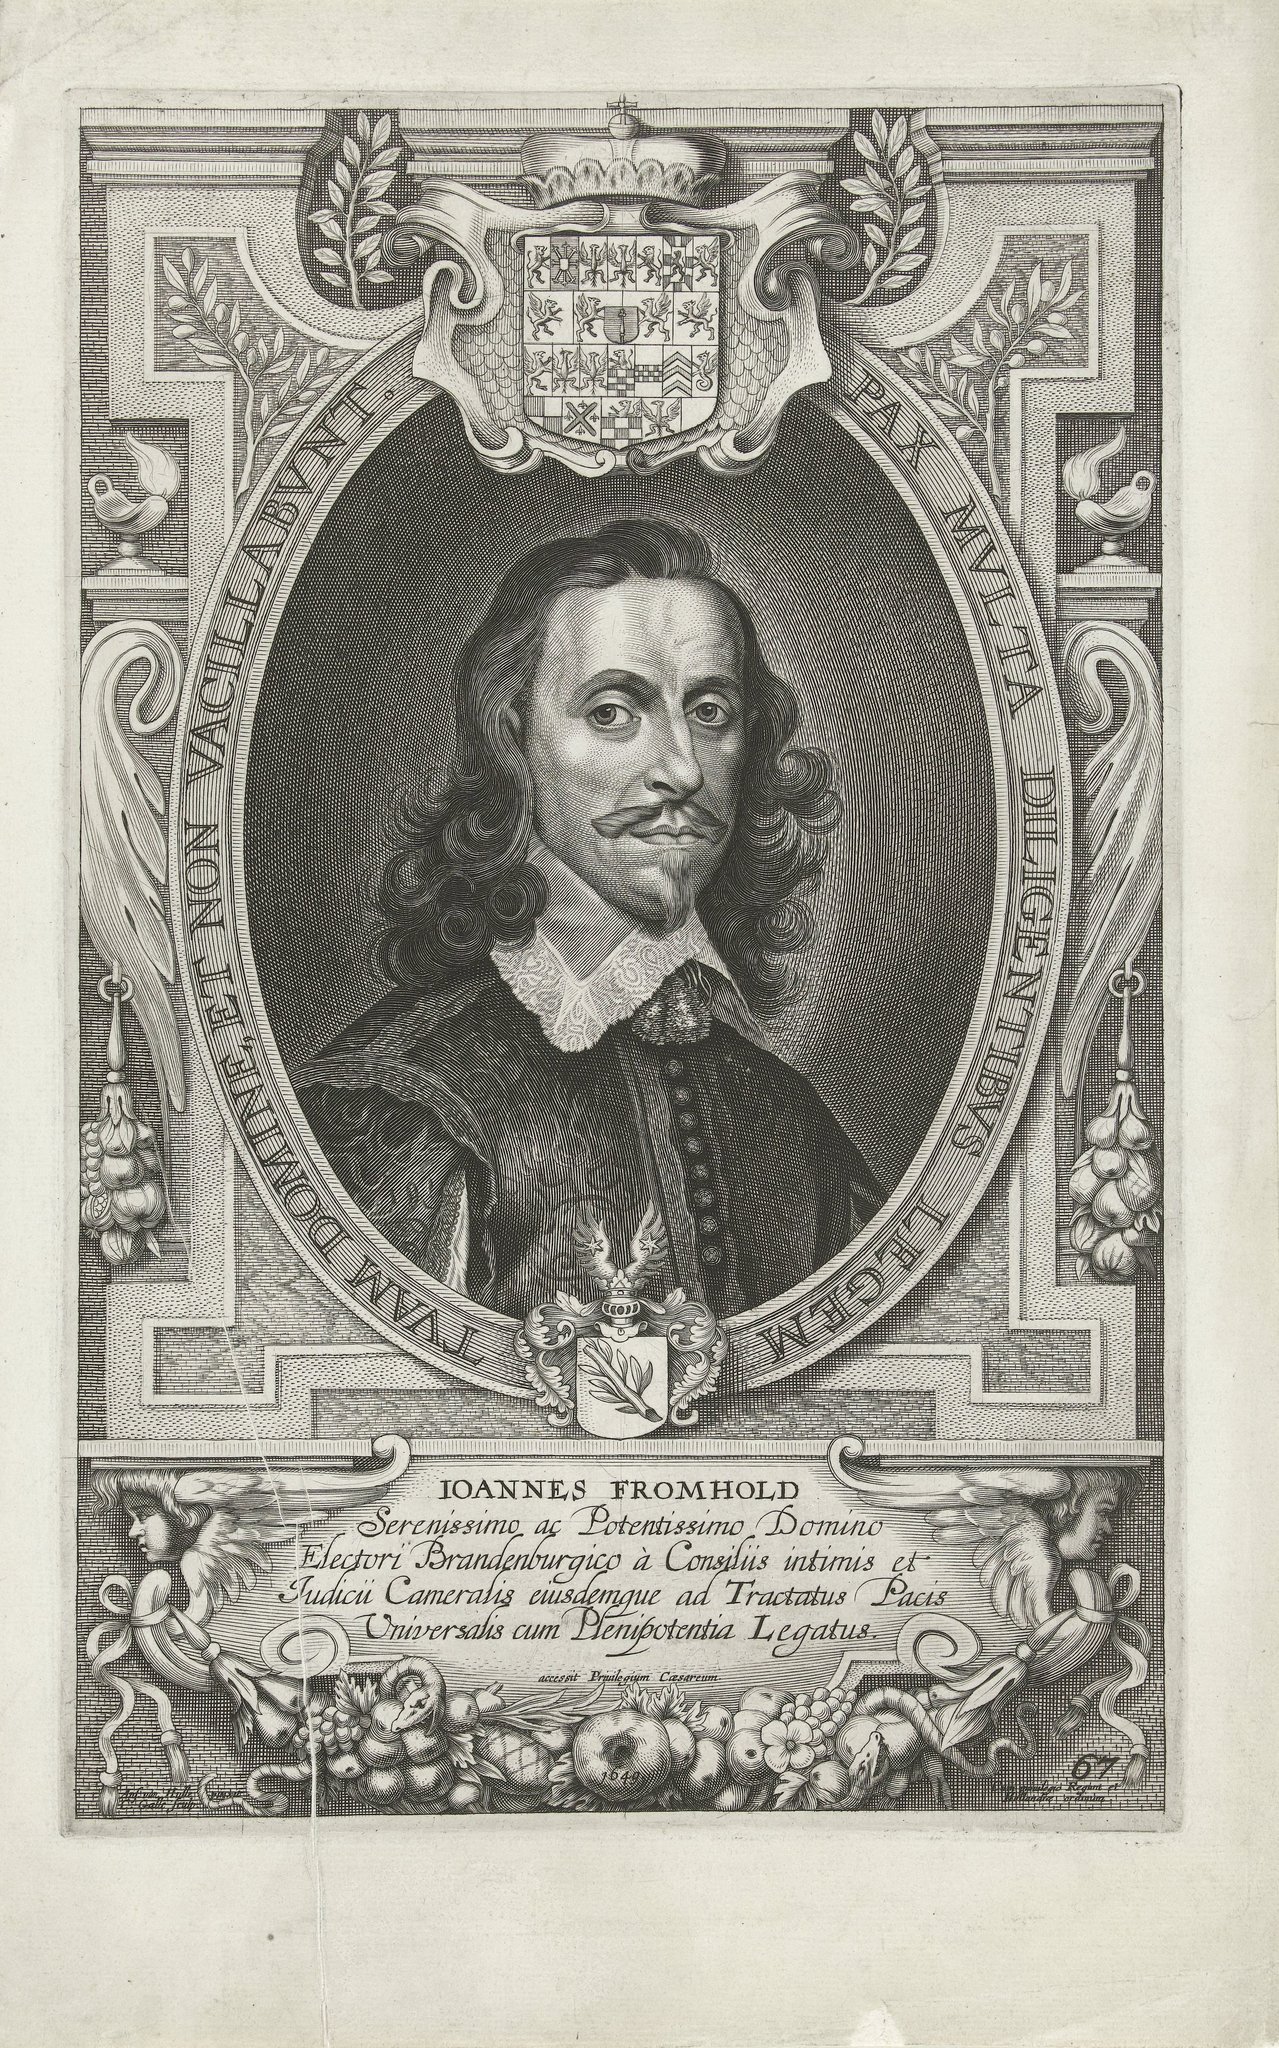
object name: print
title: Celeberrimi ad pacificandum Christiani nominis orbem legati Monasterium et Osnabrugas (...)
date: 1649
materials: paper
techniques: engraving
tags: diplomaat, johann fromhold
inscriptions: collector's mark: Lugt 2228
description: Portret van Johann Fromhold, in ovaal met randschrift, sierlijst en wapens. Fromhold was afgezant voor Brandenburg tijdens de vredesonderhandelingen van Osnabrück.